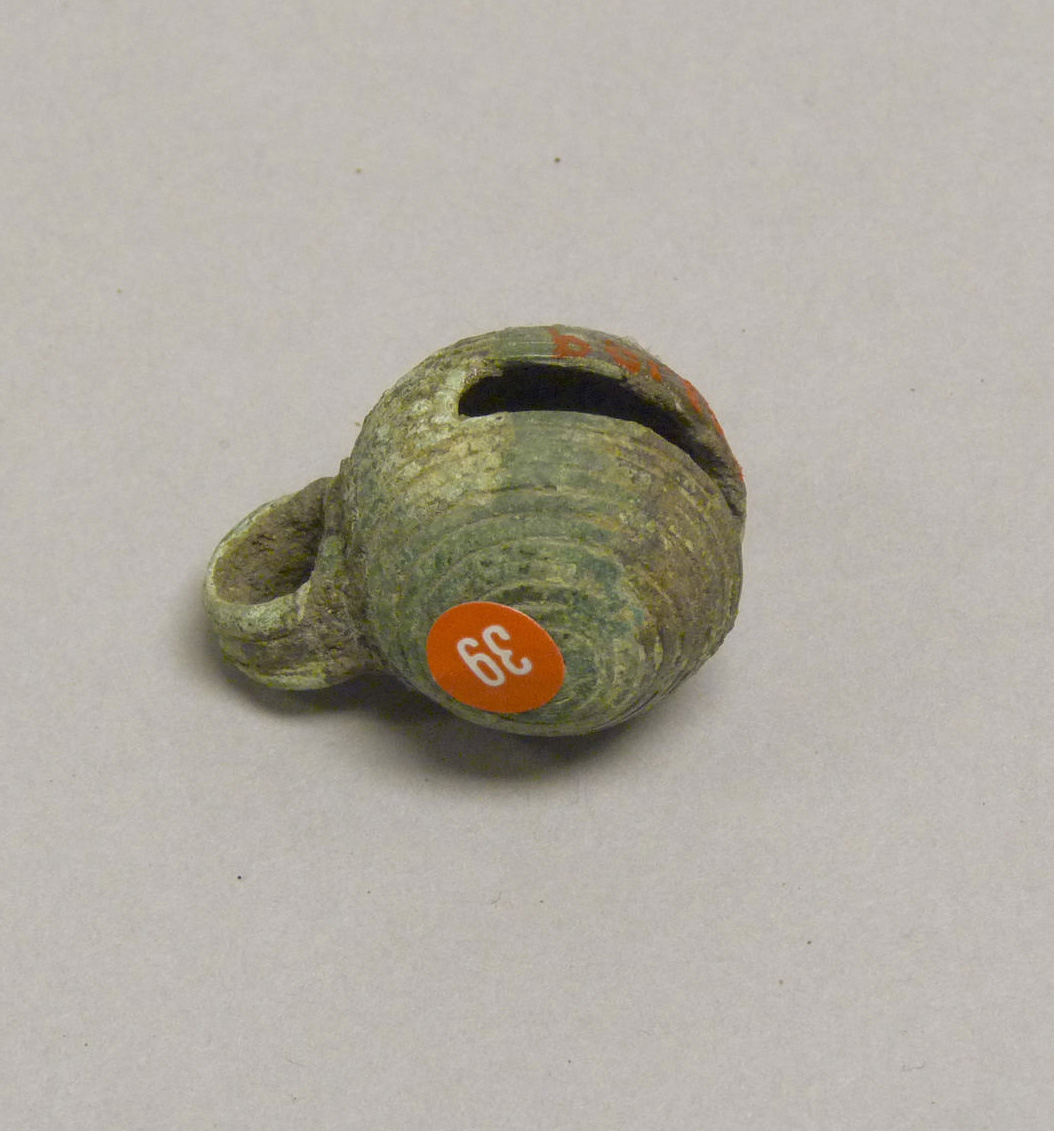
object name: bell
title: Circular Bell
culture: thai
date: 500 BCE-300 CE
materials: bronze